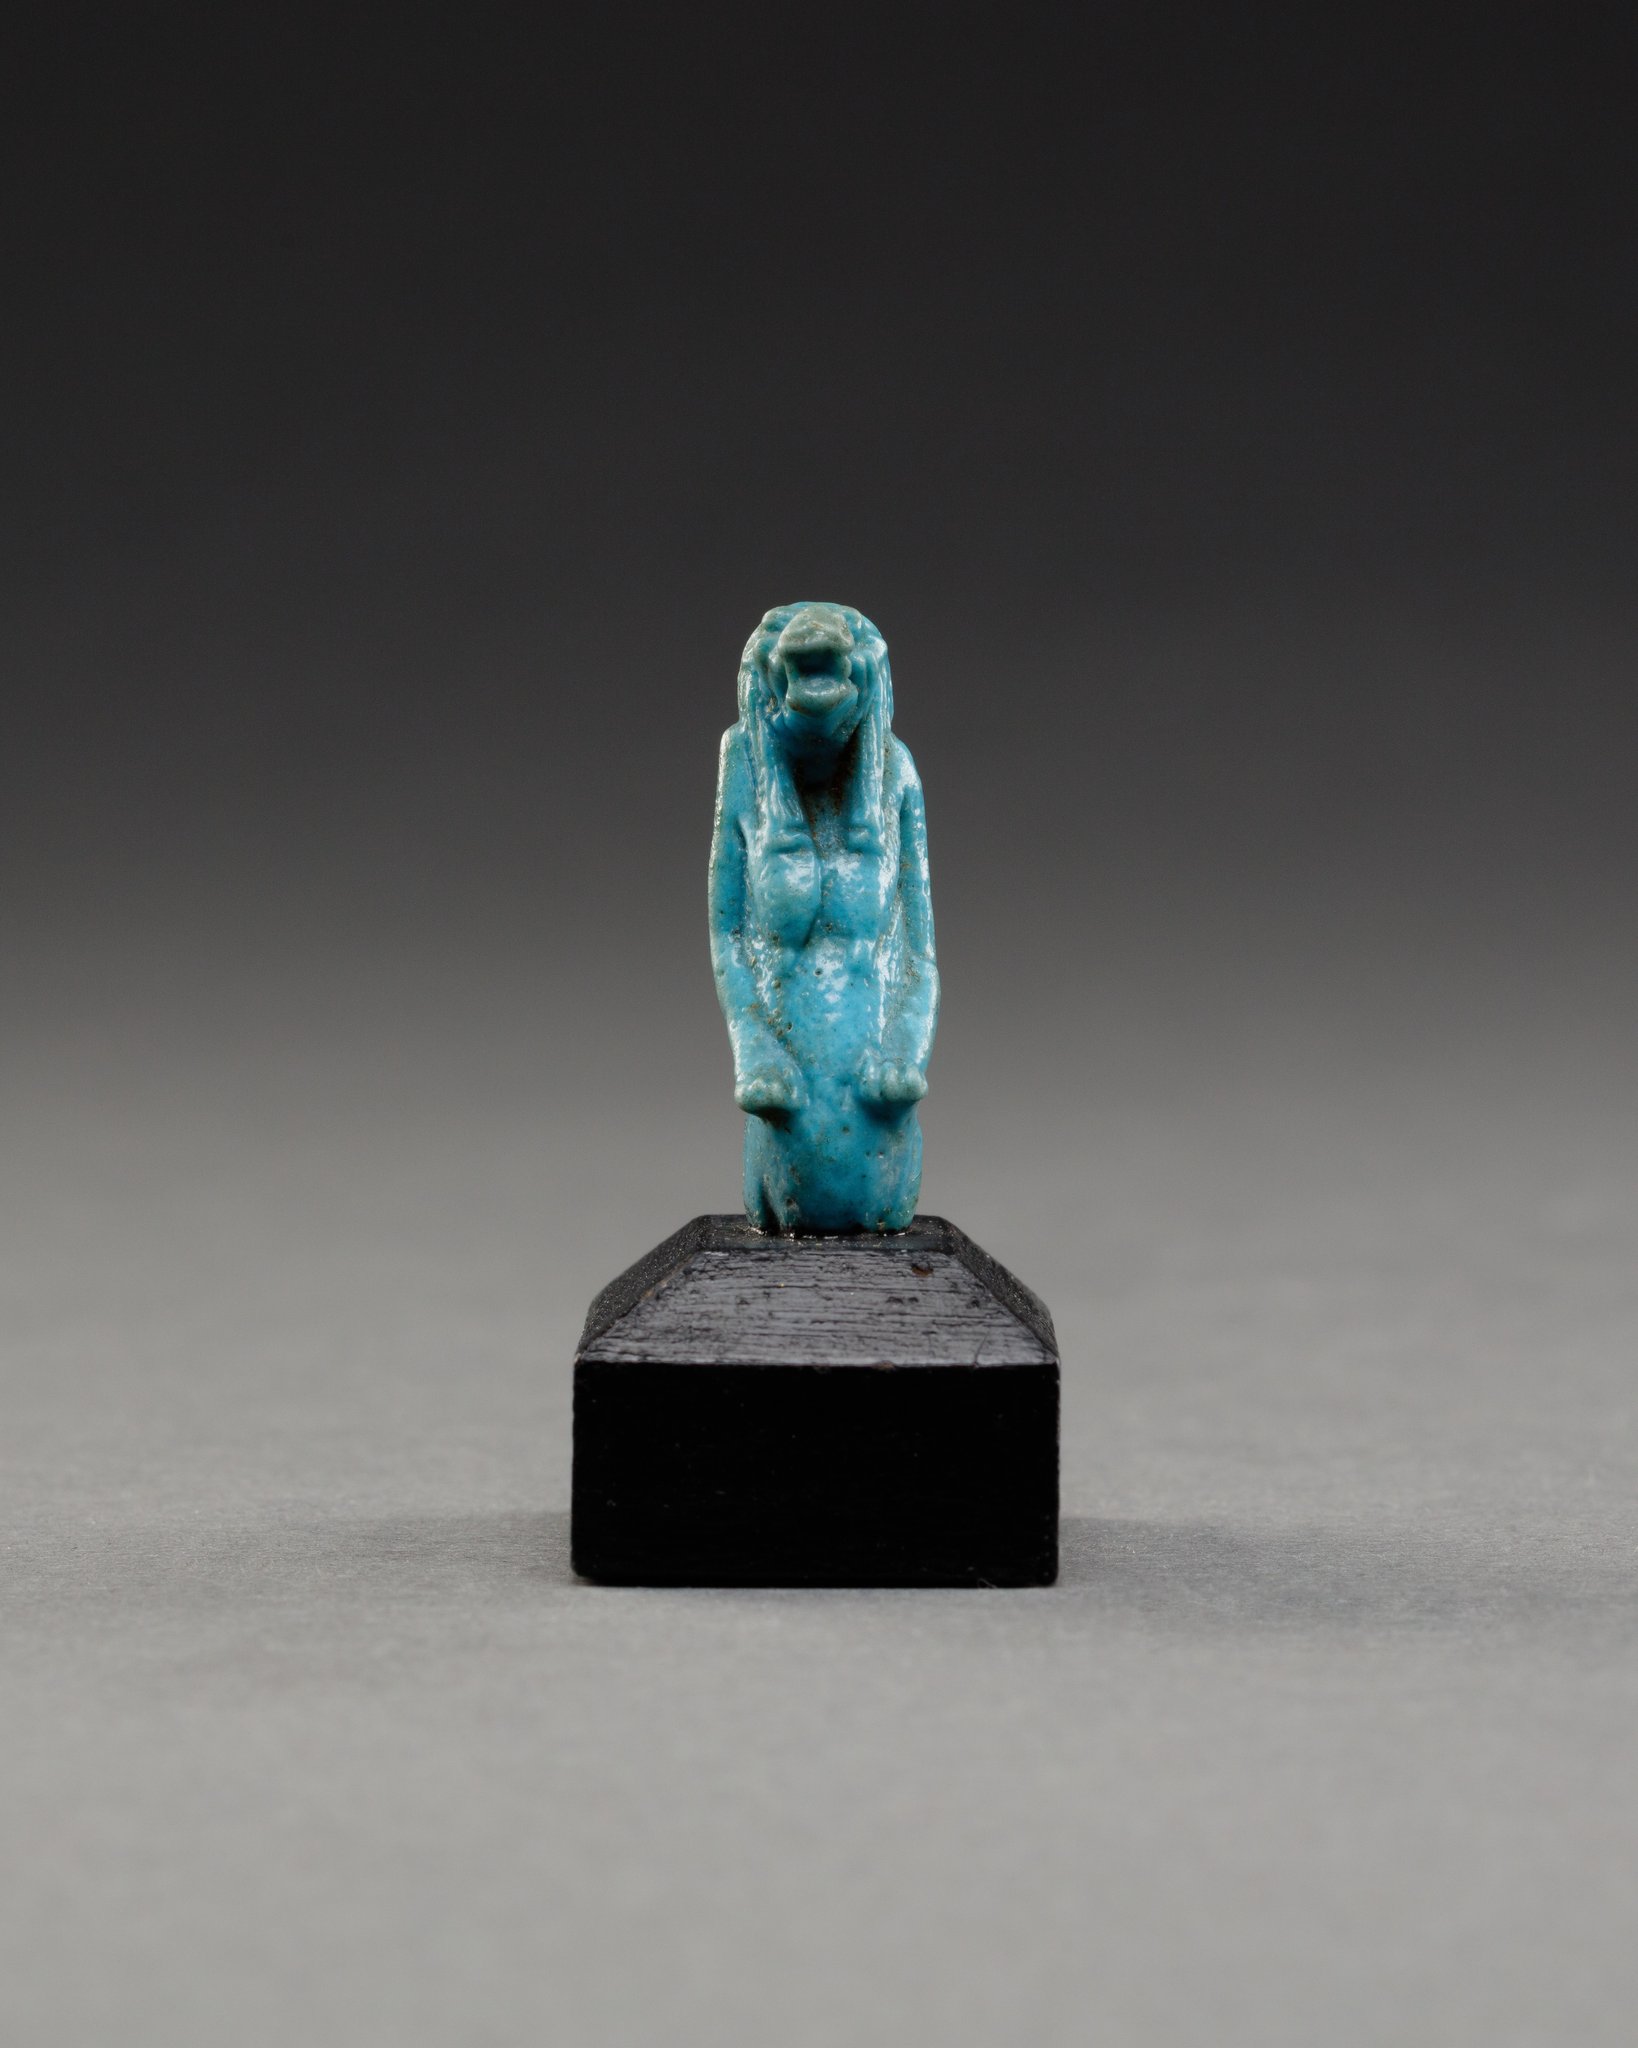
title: Partial Statuette of a Hippo Goddess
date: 664-332 BCE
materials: faience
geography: egypt